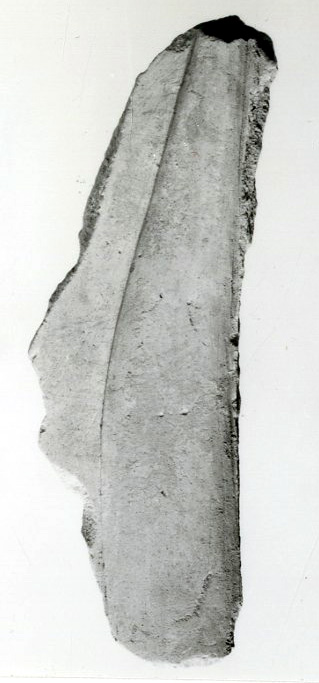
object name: relief fragment, tomb of meketre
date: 1981-1975 BCE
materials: limestone, paint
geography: egypt